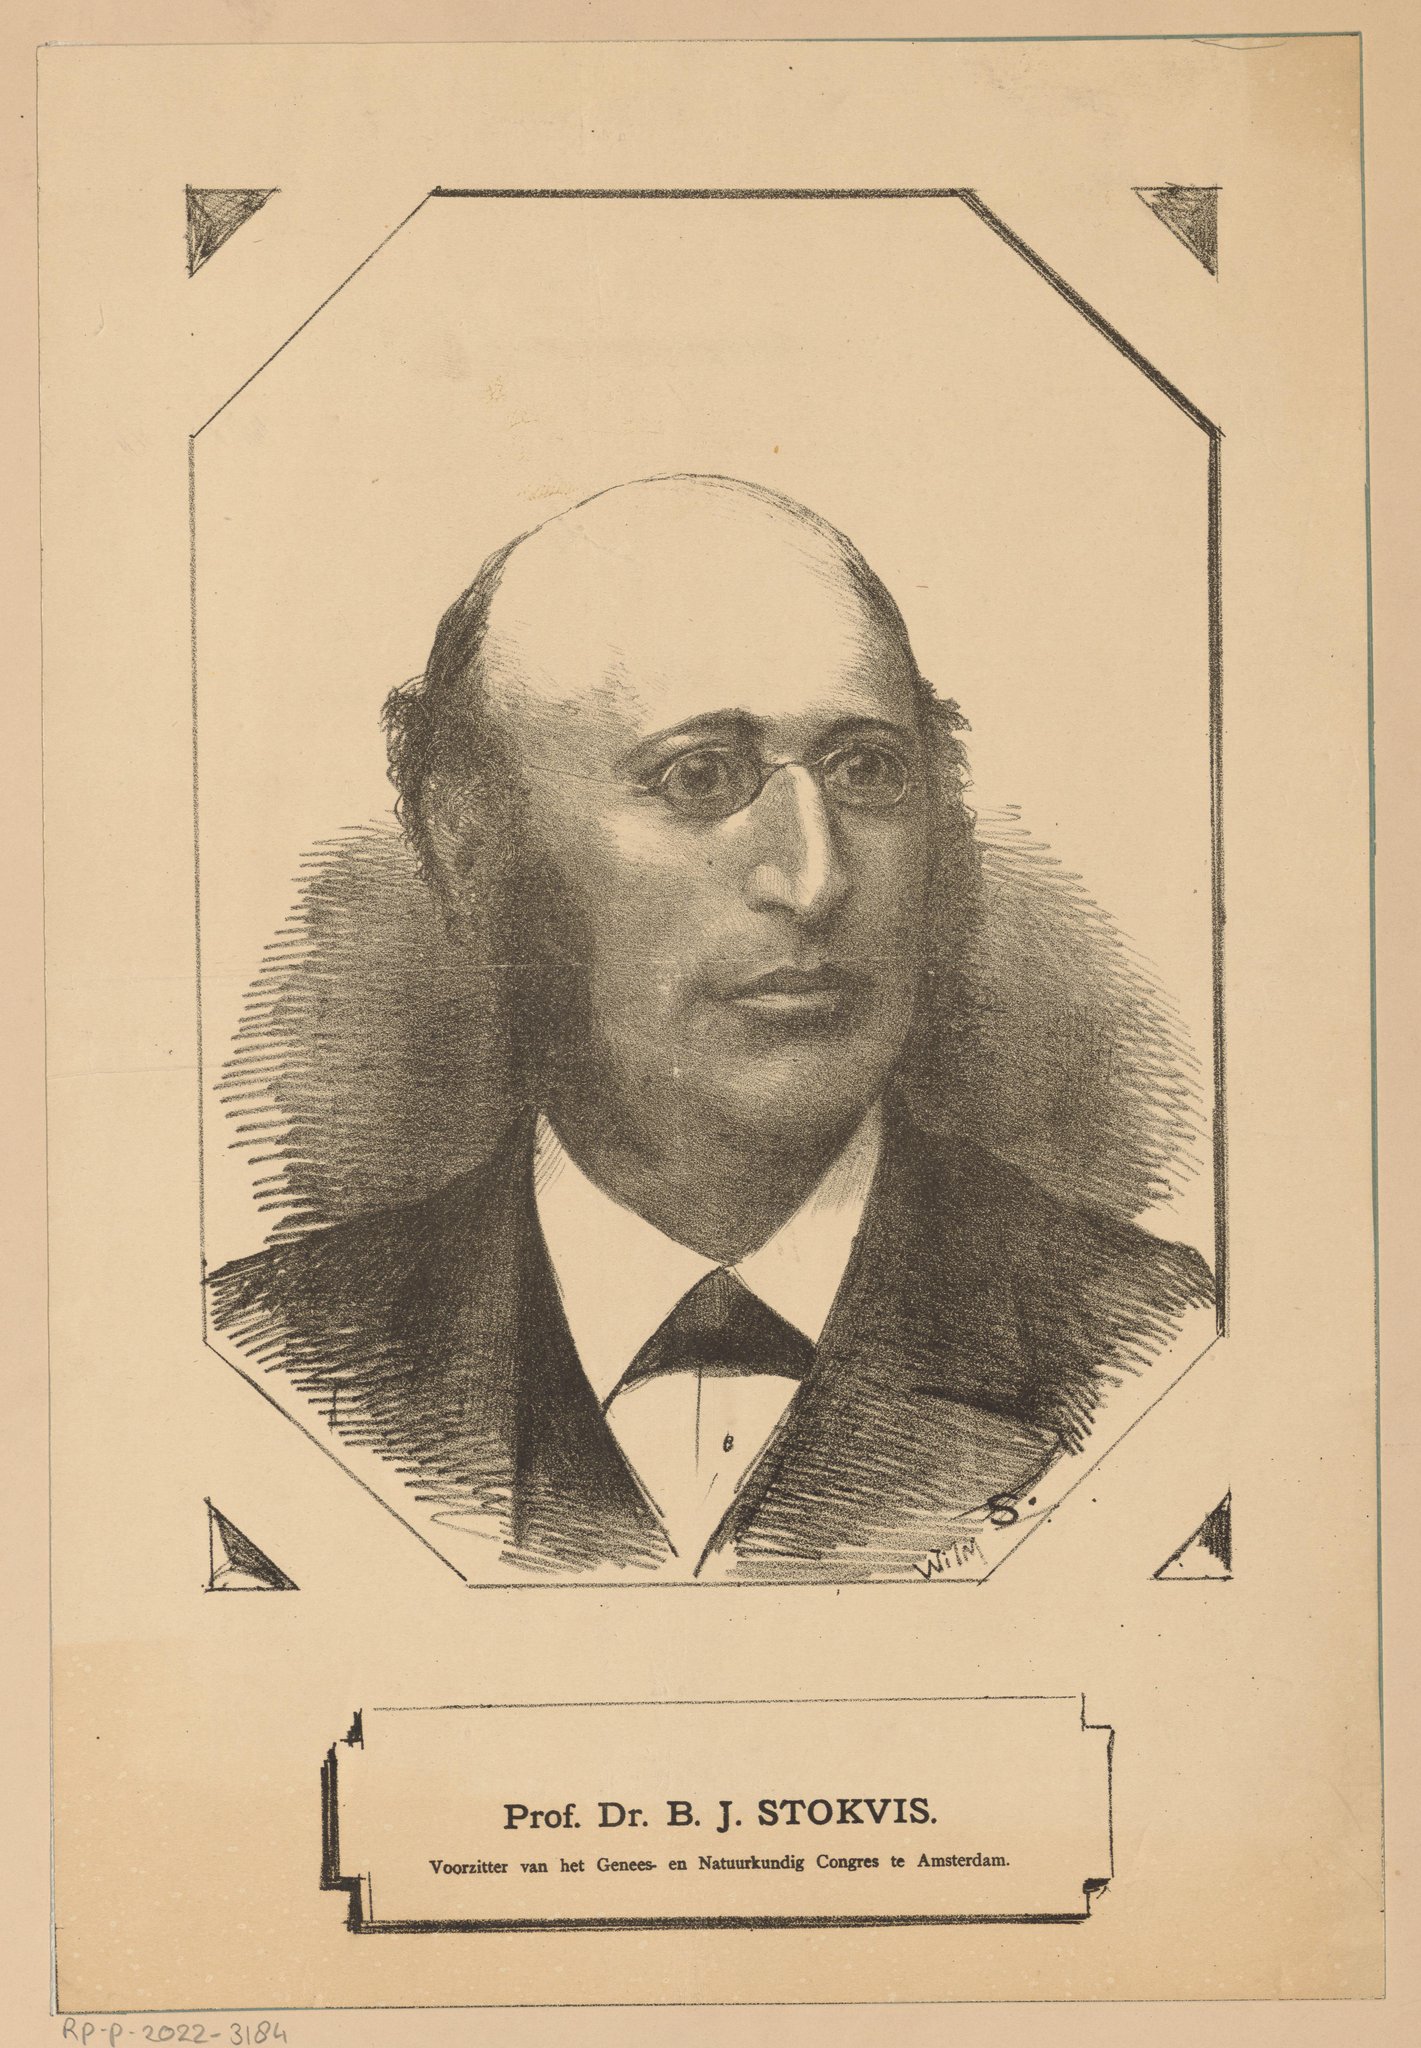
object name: print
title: Portret van Barend Joseph Stokvis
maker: willem steelink (ii)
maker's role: draughtsman, print maker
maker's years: 1856-1928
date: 1887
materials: paper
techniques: lithograph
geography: netherlands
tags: amsterdam, barend joseph stokvis, historical persons, physician, doctor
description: Met eenregelig onderschrift in het Nederlands.